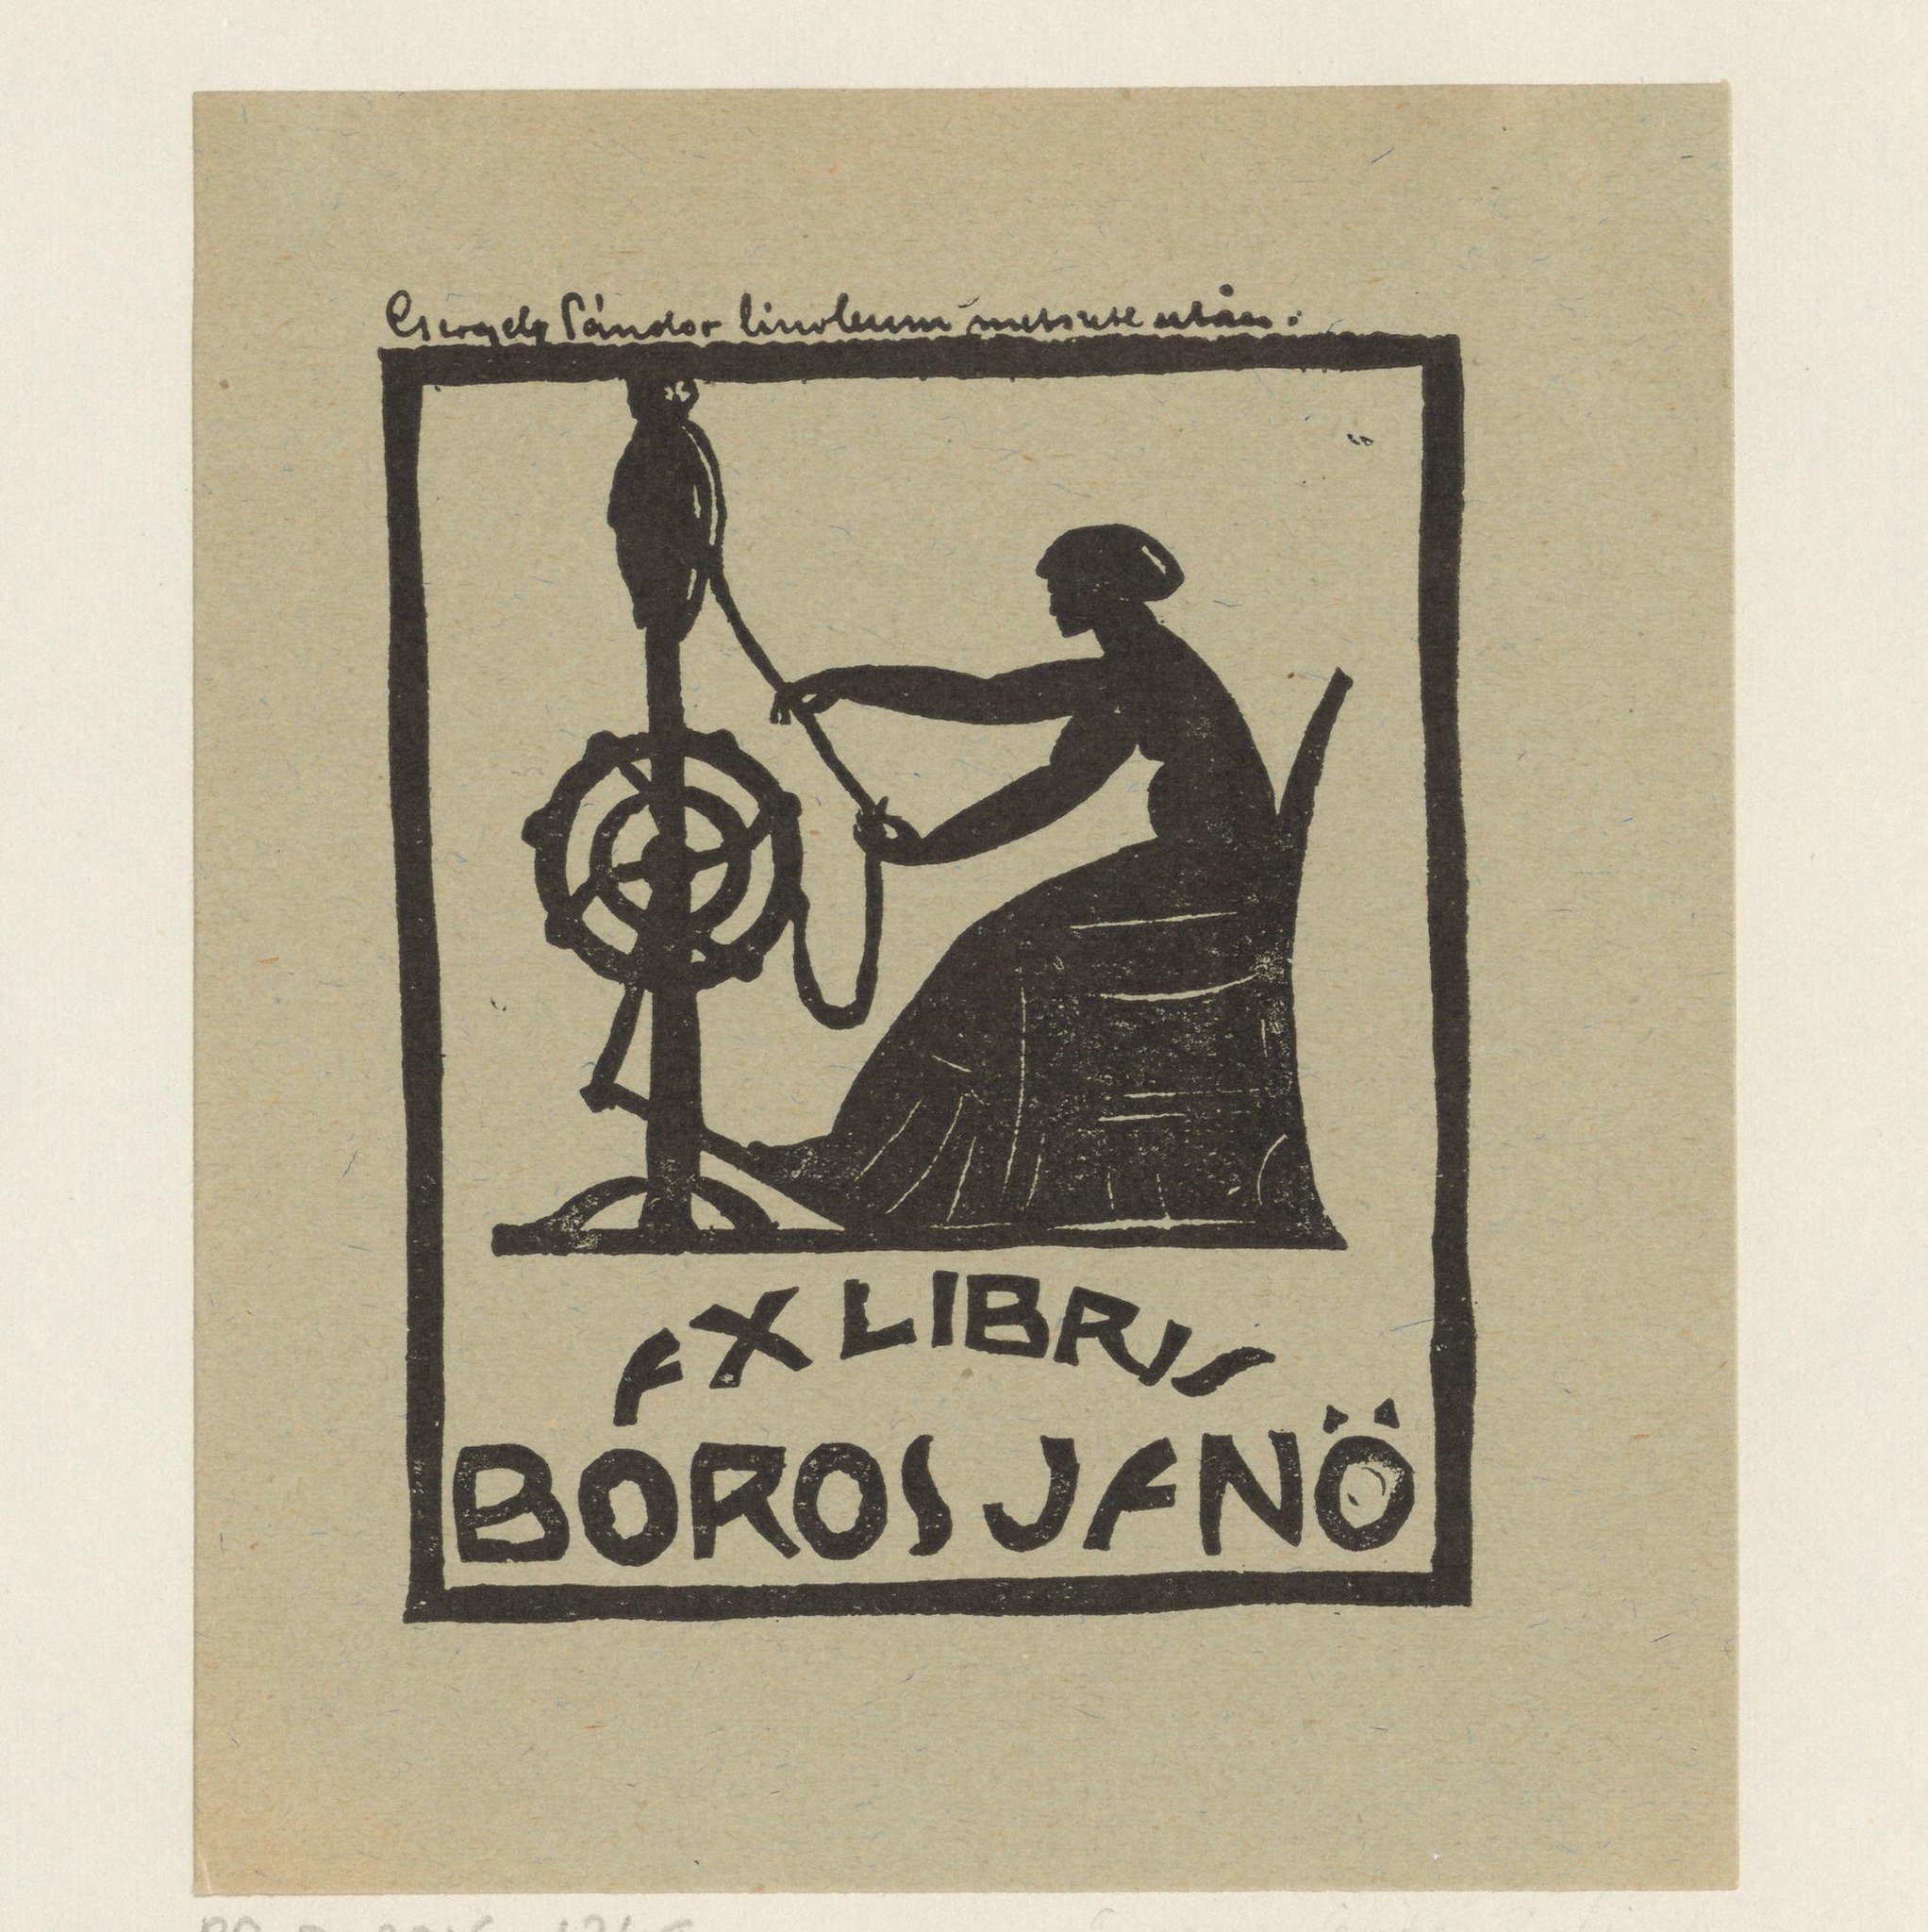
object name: bookplate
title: Ex libris van Boros Jenö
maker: alexander gergely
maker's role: print maker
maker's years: 1888-1932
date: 1899-1932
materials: paper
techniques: linocut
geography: hungary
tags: spinning-wheel